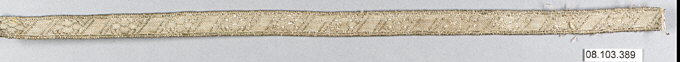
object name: galloon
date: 1601-1800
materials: metal thread